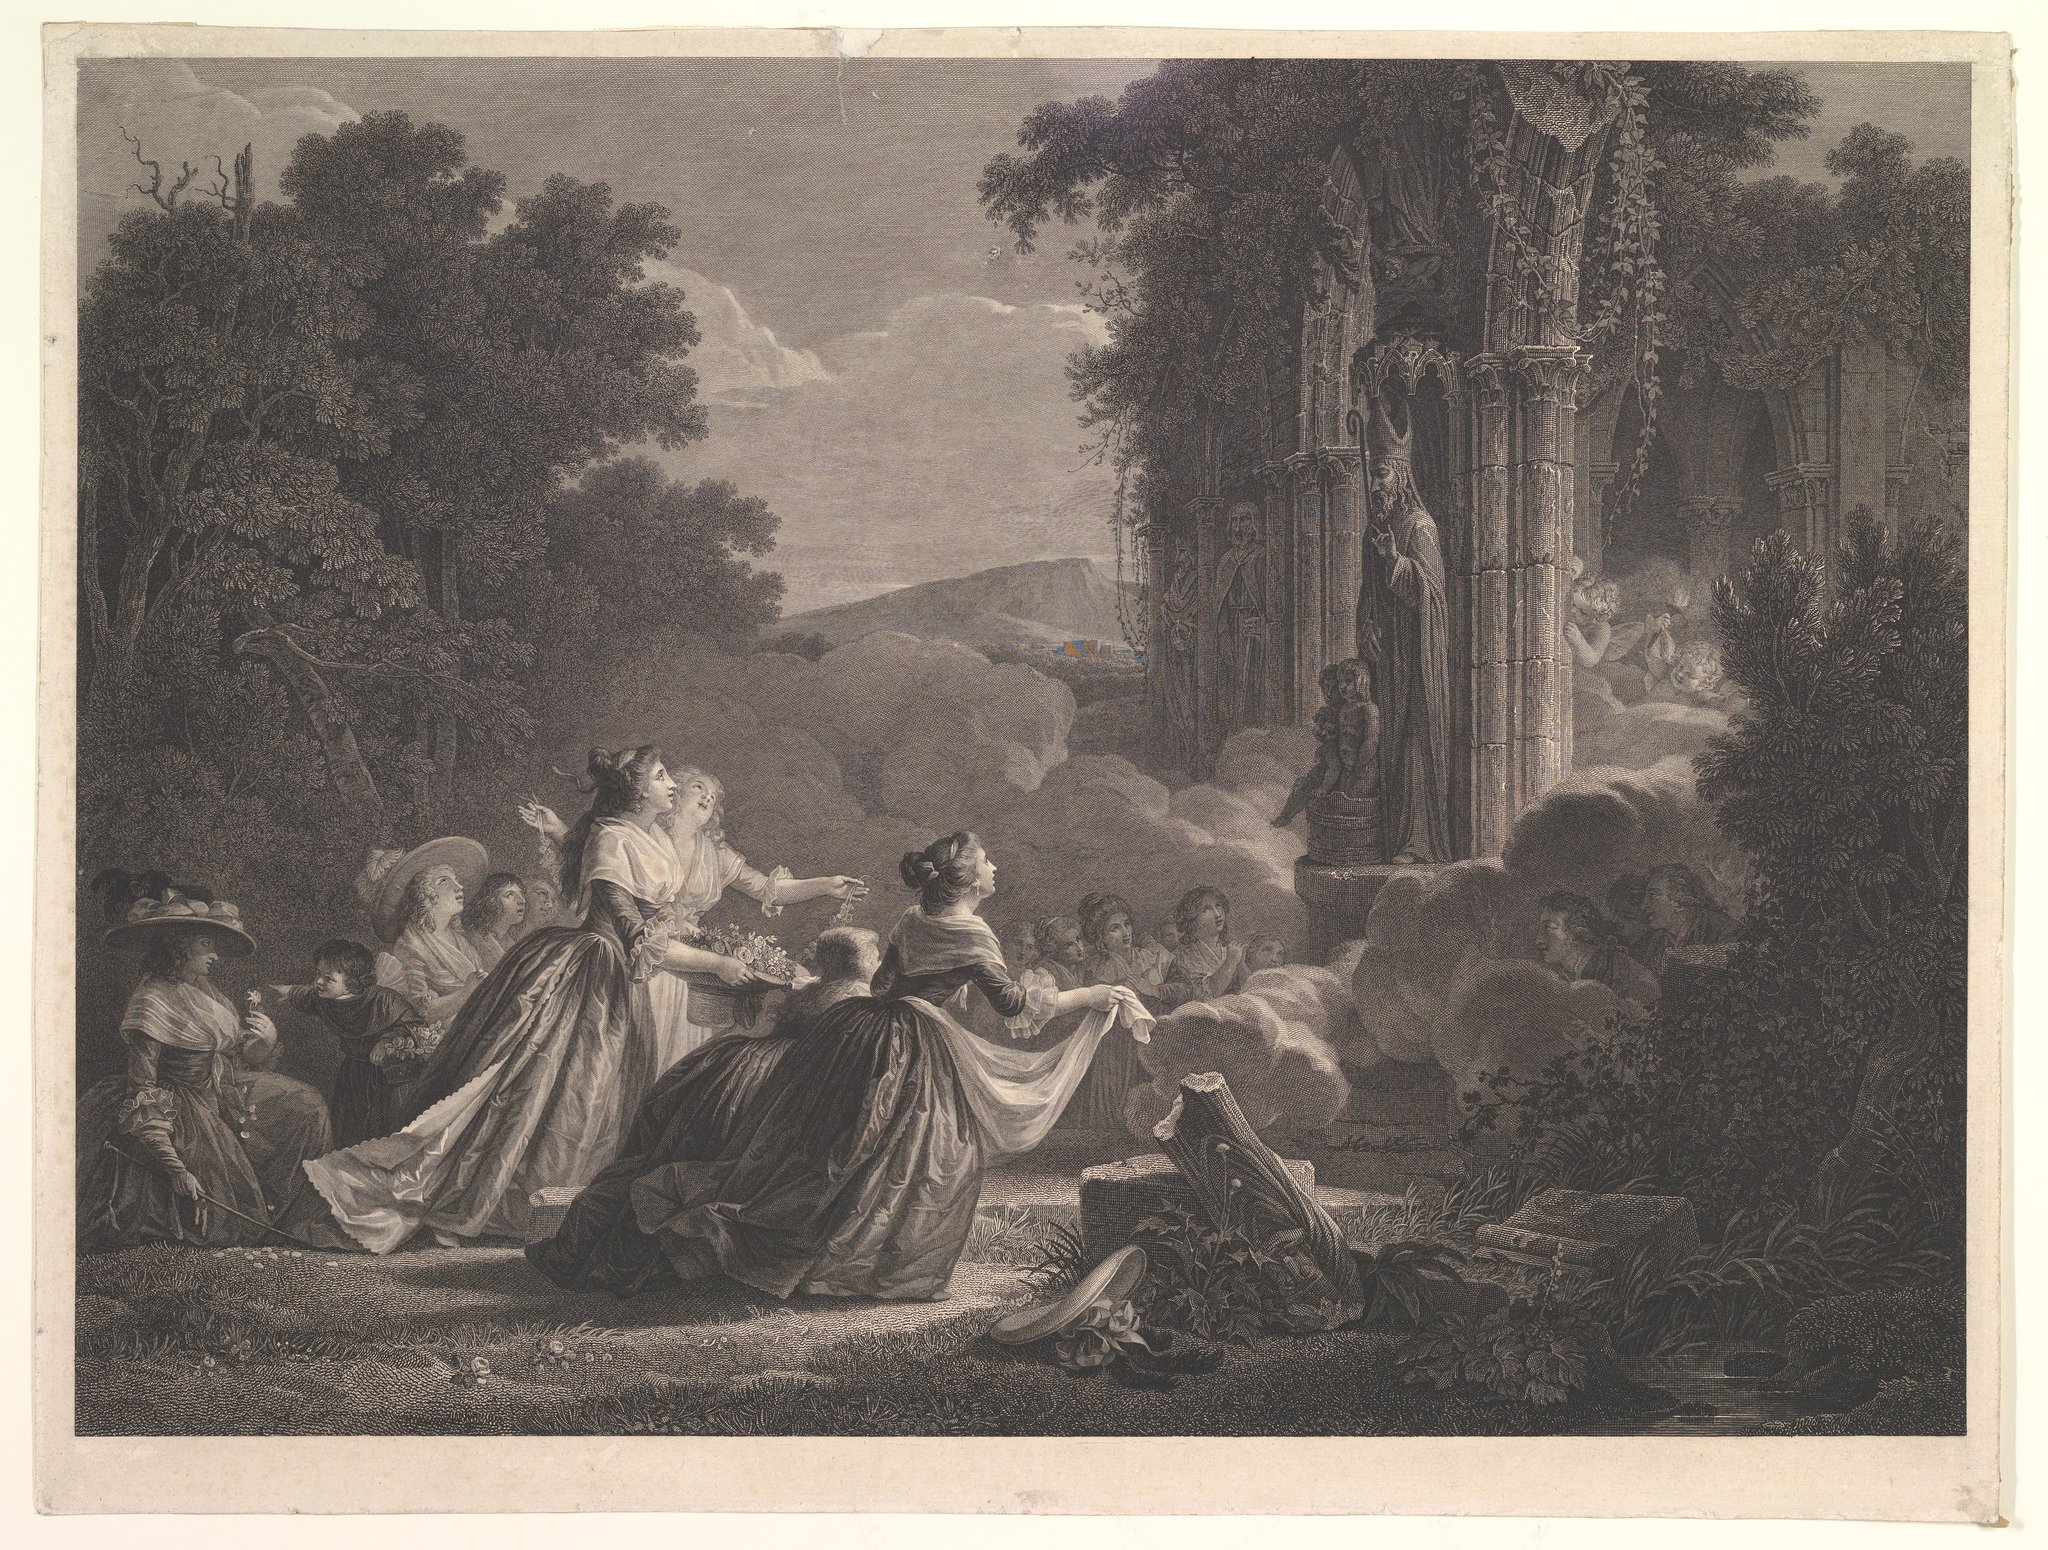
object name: print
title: Pelerinage a Saint Nicolas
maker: jean honoré fragonard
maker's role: artist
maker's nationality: french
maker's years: 1732-1806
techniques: etching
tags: women,saints